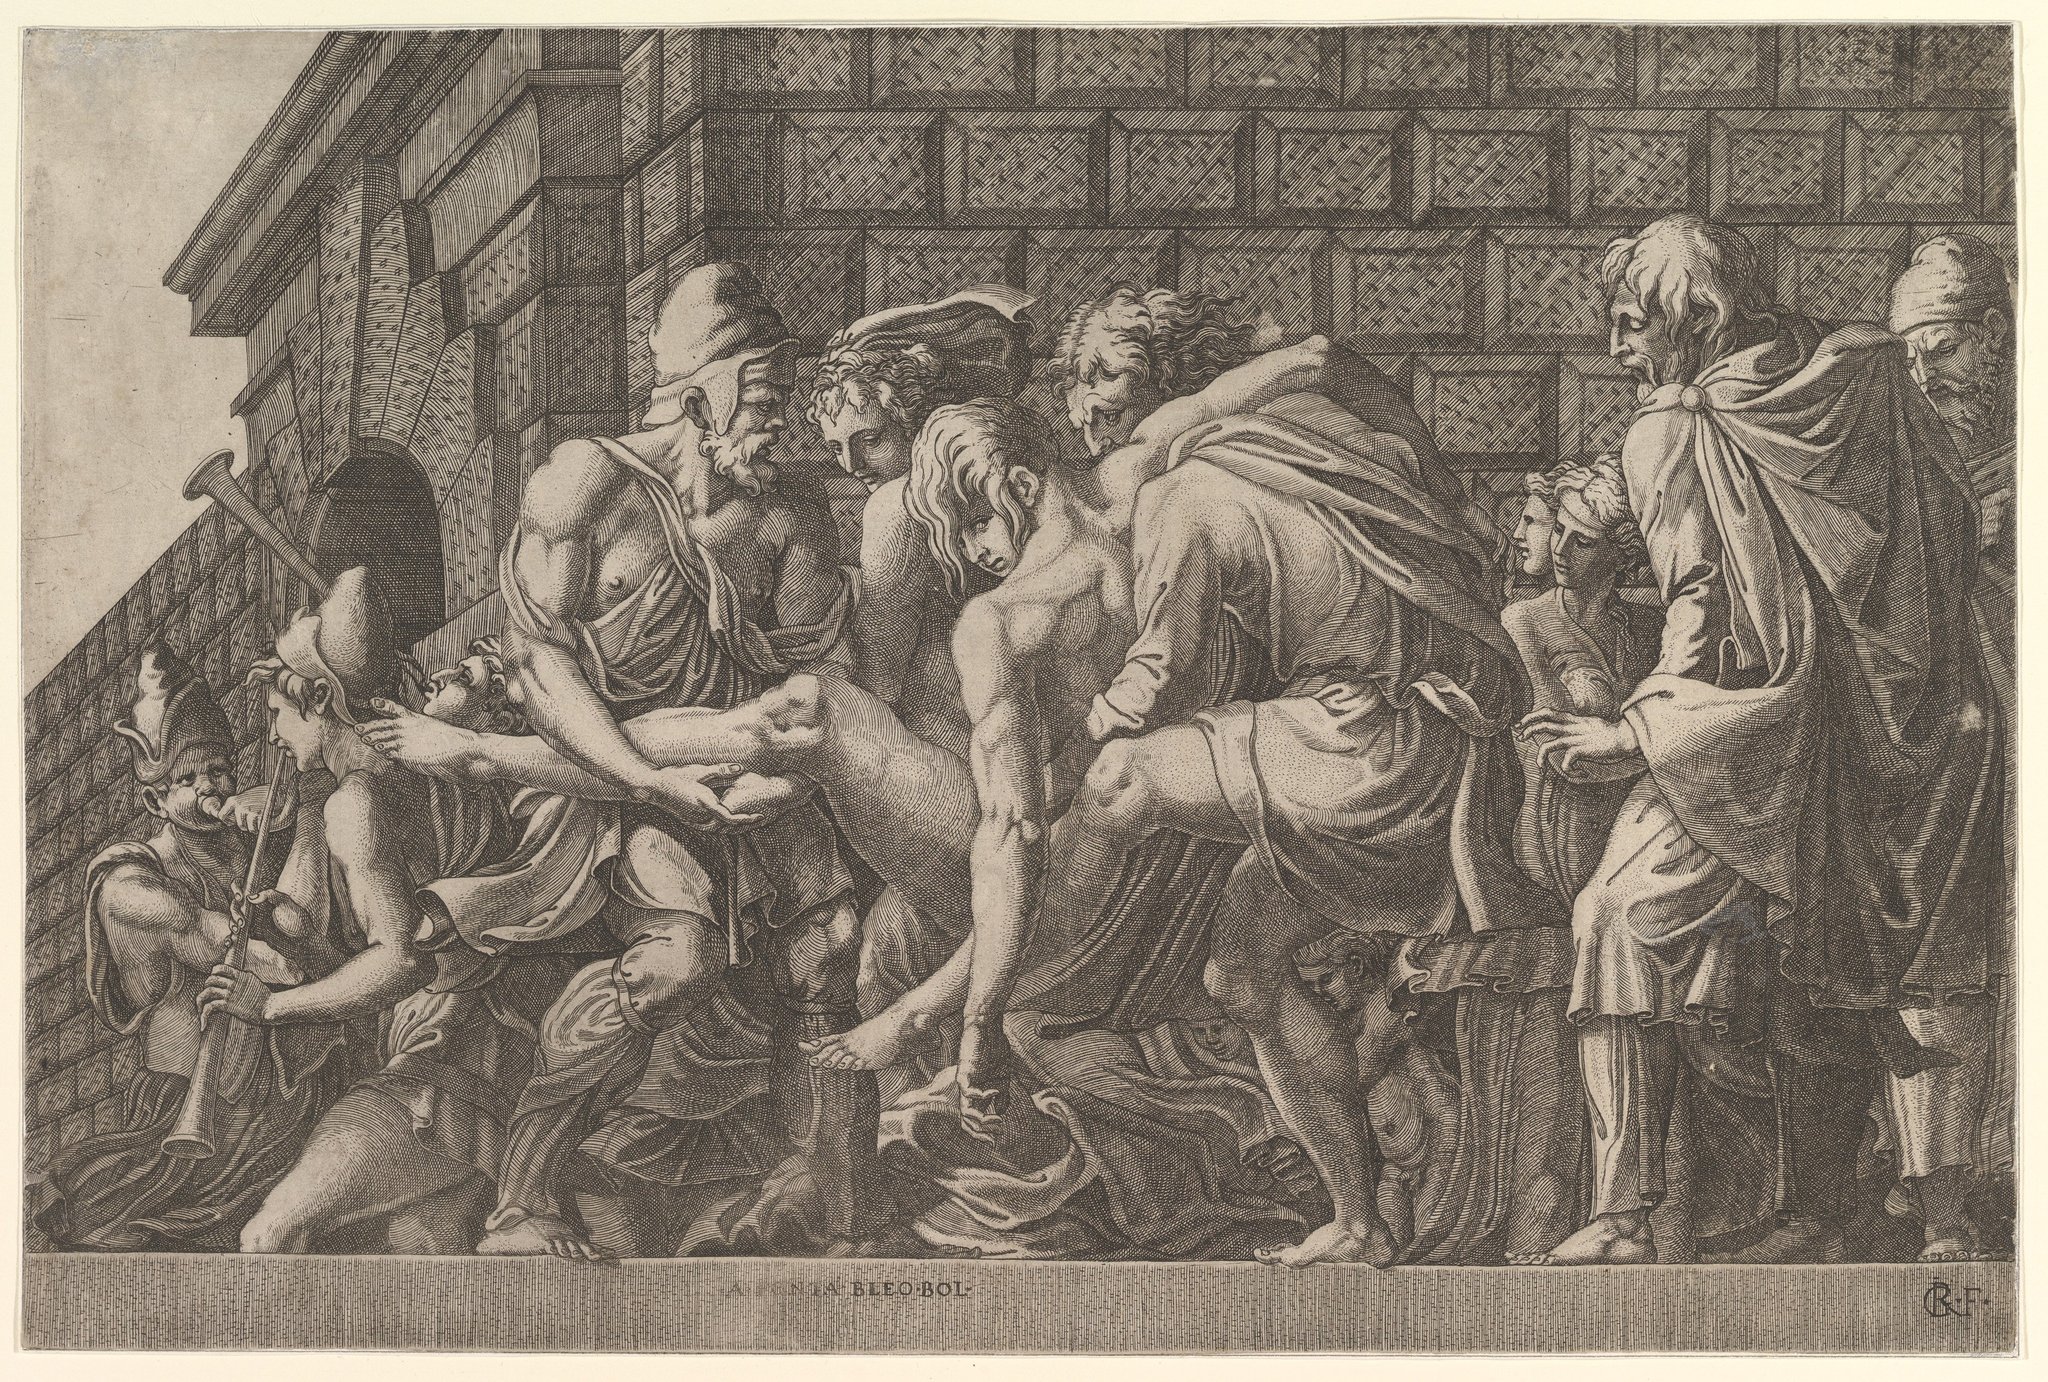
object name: print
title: The Wounded Paris Carried from the Field of Battle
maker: master fg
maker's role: artist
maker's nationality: italian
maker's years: 1530-1560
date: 1540-1560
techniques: engraving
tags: musical instruments,soldiers,men